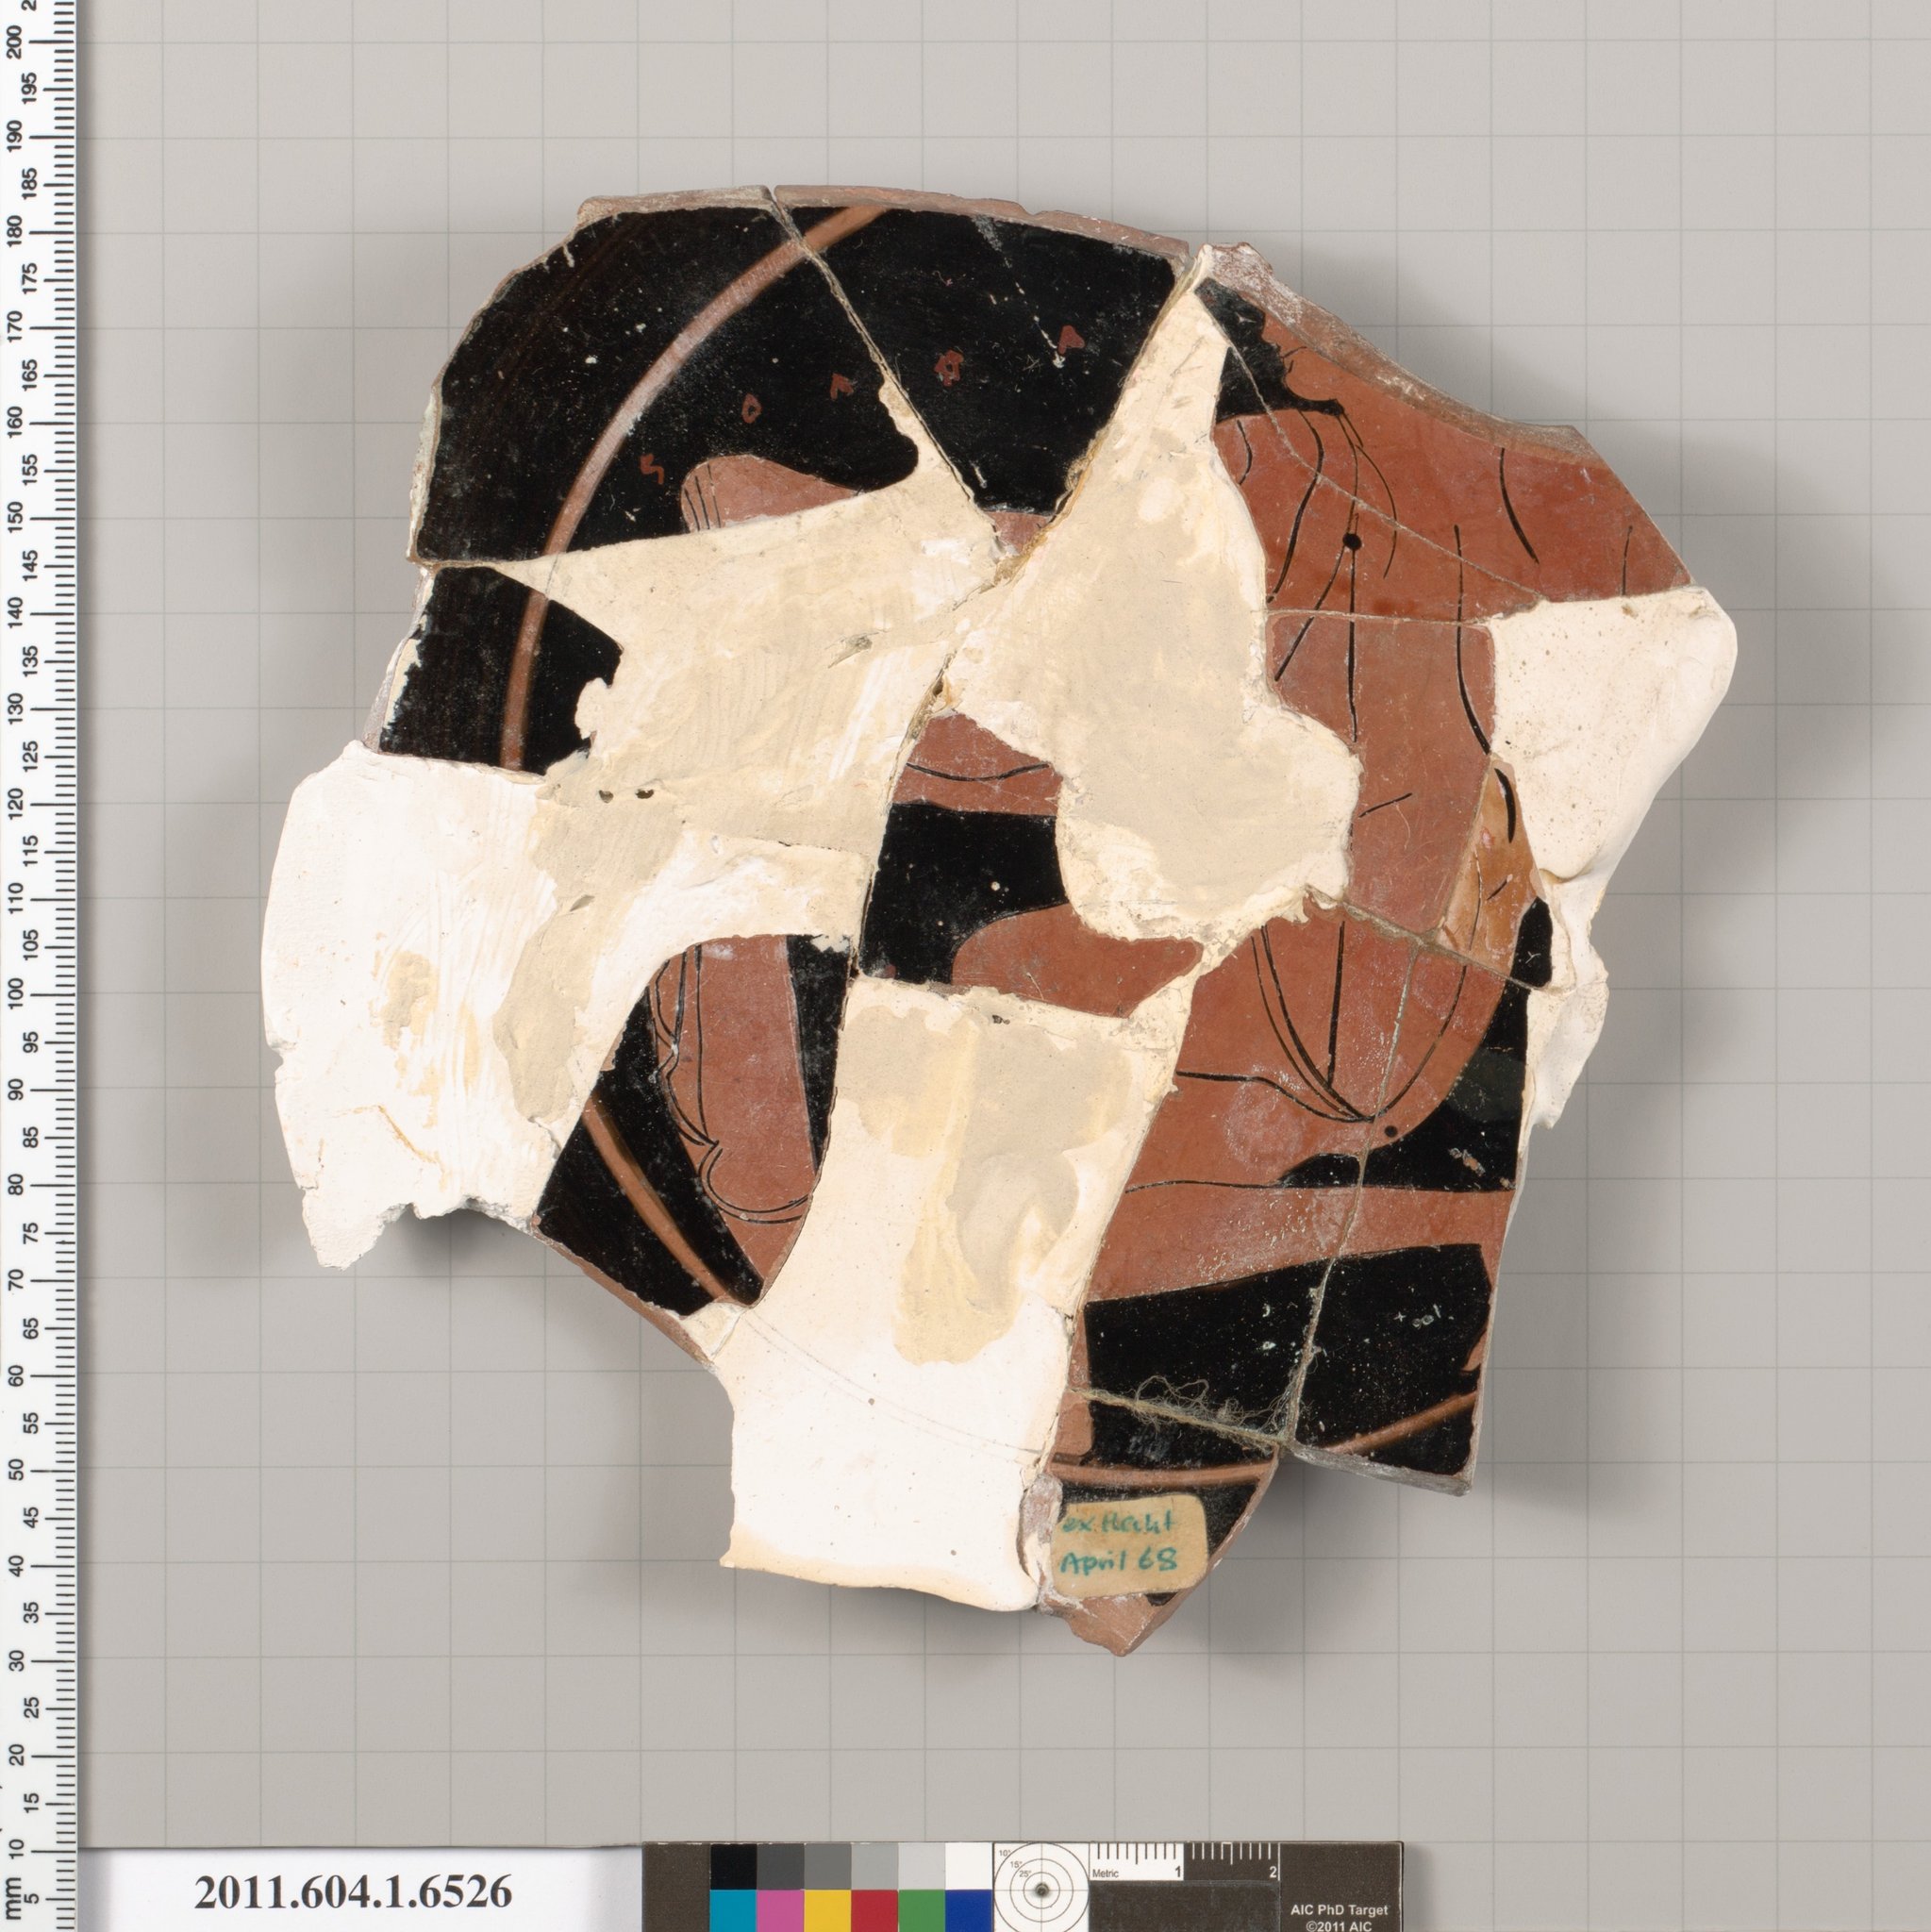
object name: kylix fragment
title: Terracotta fragment of a kylix (drinking cup)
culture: greek, attic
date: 490-480 BCE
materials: terracotta